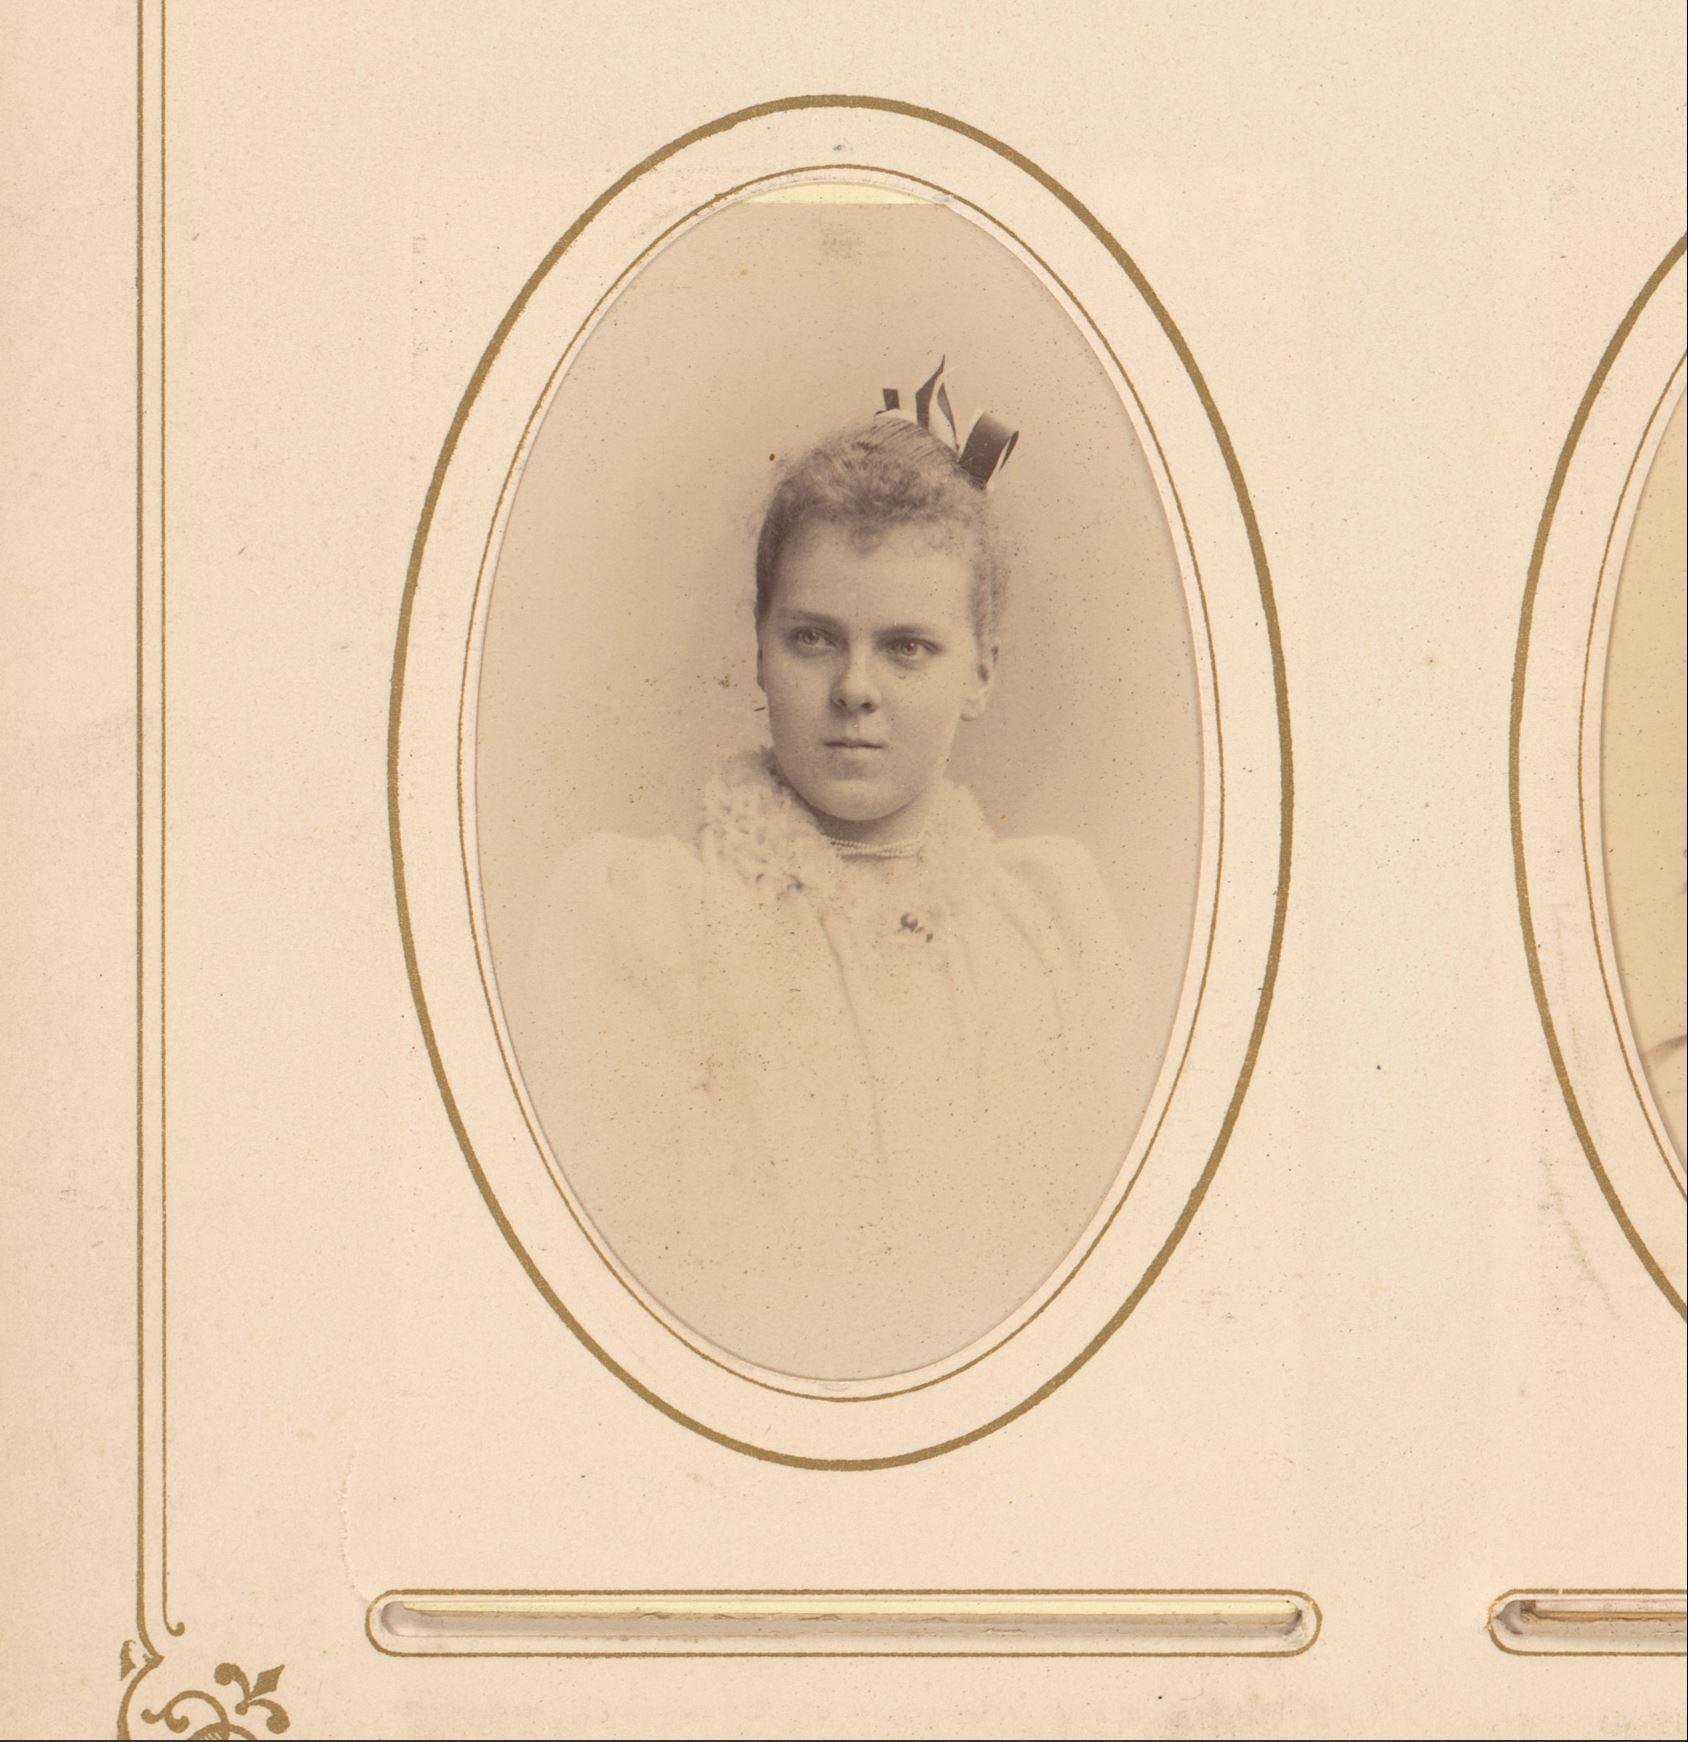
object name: carte de visite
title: Portret van een jonge vrouw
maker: emil tiedemann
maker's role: fotograaf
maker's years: 1858-1892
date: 1859-1892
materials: cardboard, photographic support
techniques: albumen print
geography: germany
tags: adolescent, young woman, maiden, historical persons - bb - woman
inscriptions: annotation: ‘Mutter, [.]m 19. jahren’, inscription: ‘PHOTOGRAPHISCHER SALON/ Emil Tiedemann/ 12 Richtweg 12/ BREMEN.’